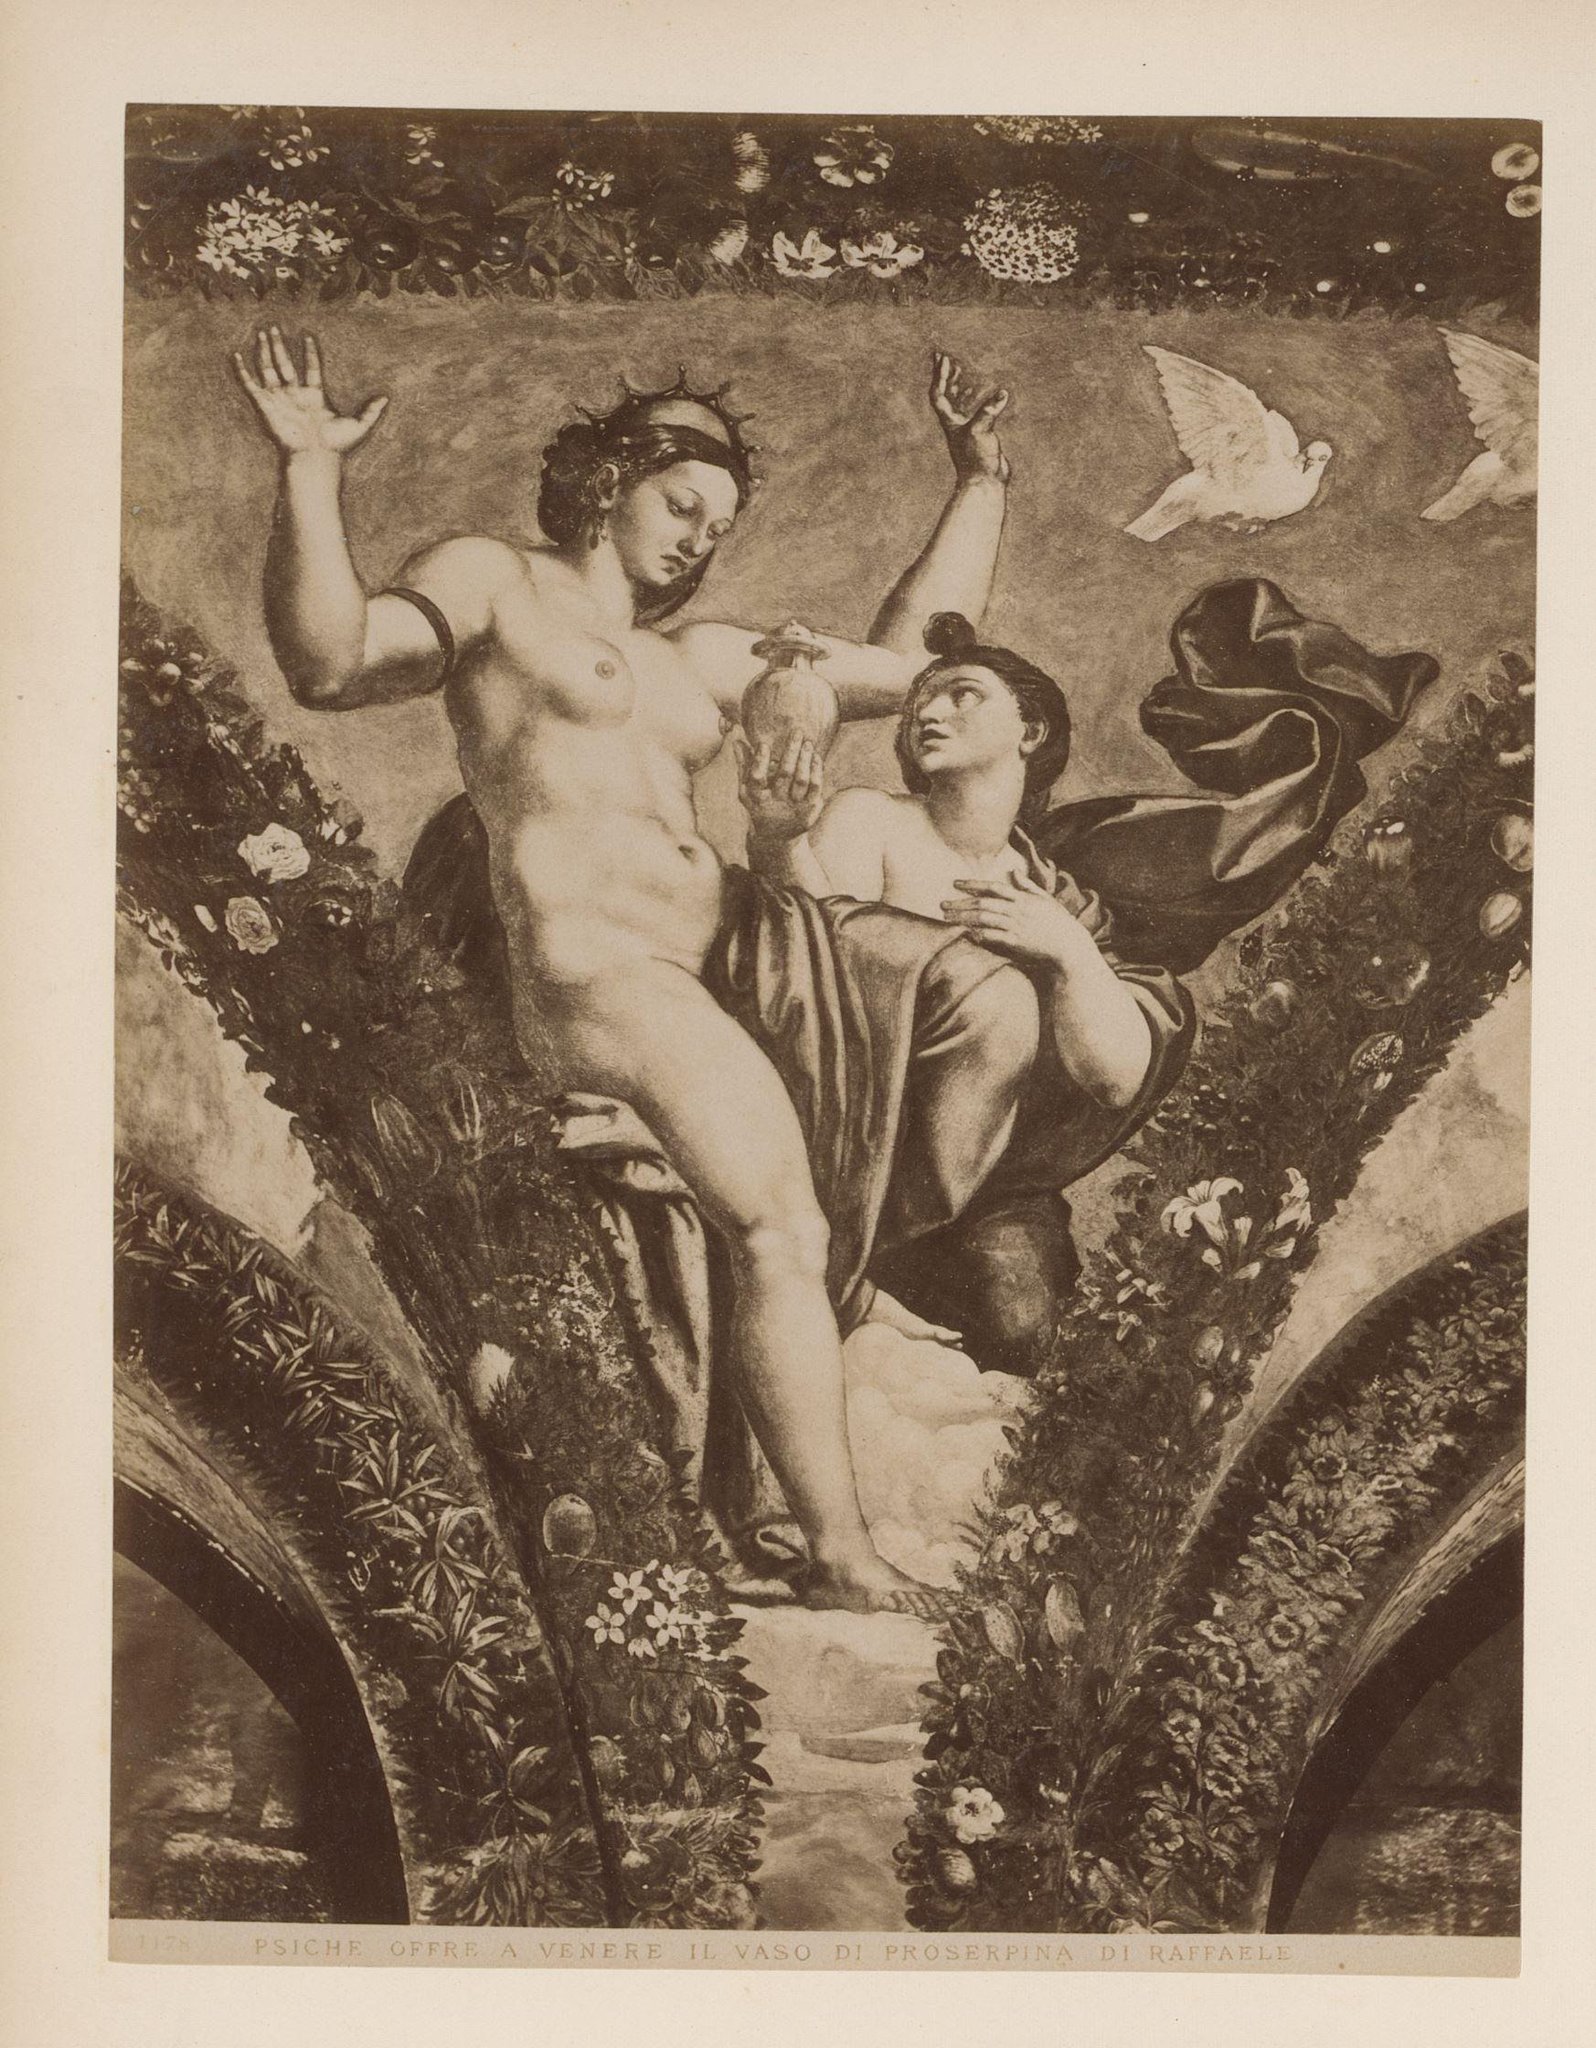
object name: reproduction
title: Psiche offre a Venere il vaso di Proserpina di Raffaele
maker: domenico anderson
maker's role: fotograaf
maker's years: 1854-1939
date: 1870-1890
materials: paper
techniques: albumen print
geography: villa farnesina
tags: picture, painting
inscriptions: inscription: ‘1178 PSICHE OFFRE A VENERE IL VASO DI PROSERPINA DI RAFFAELE’